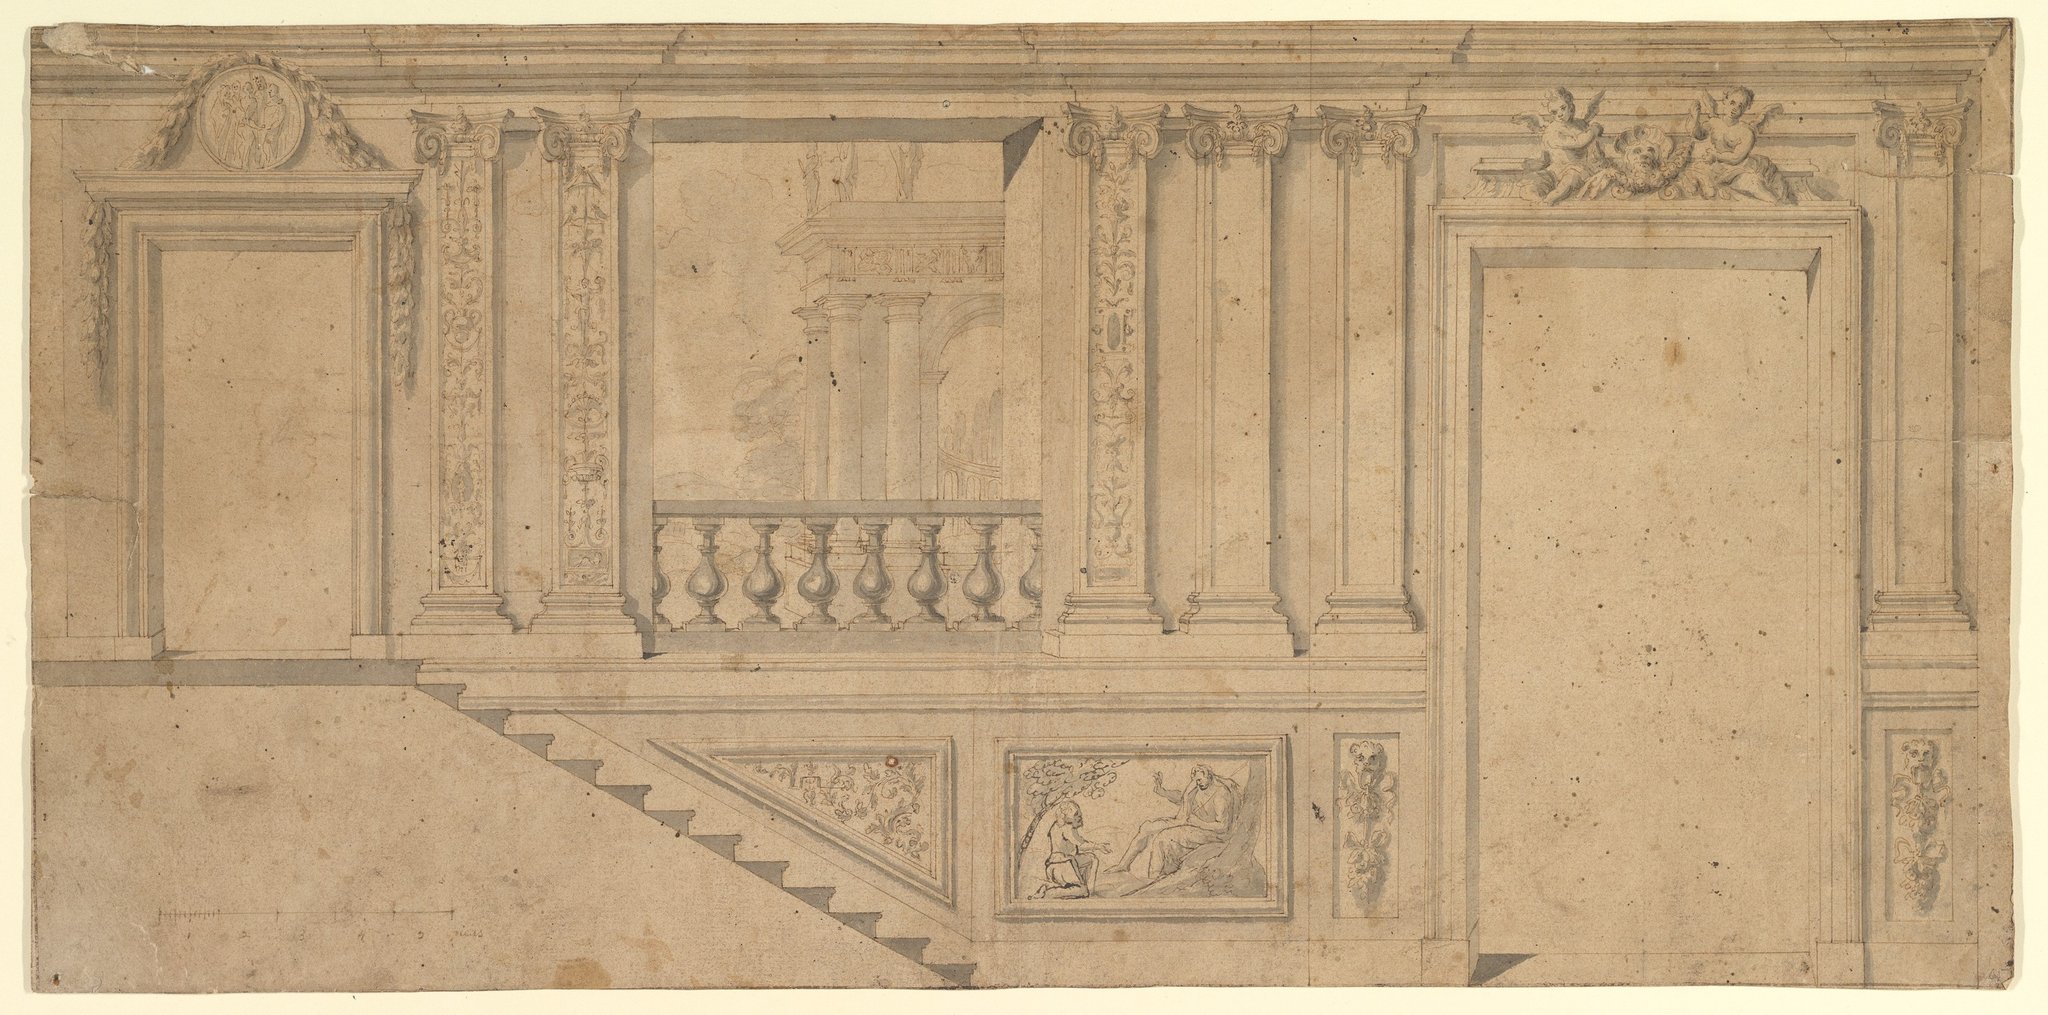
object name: drawing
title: Design for Interior Wall Decoration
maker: anonymous, italian, piedmontese, 18th century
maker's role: artist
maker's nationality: italian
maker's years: 1700-1800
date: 1700-1780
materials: ink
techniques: brush, pen, wash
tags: architecture,interiors